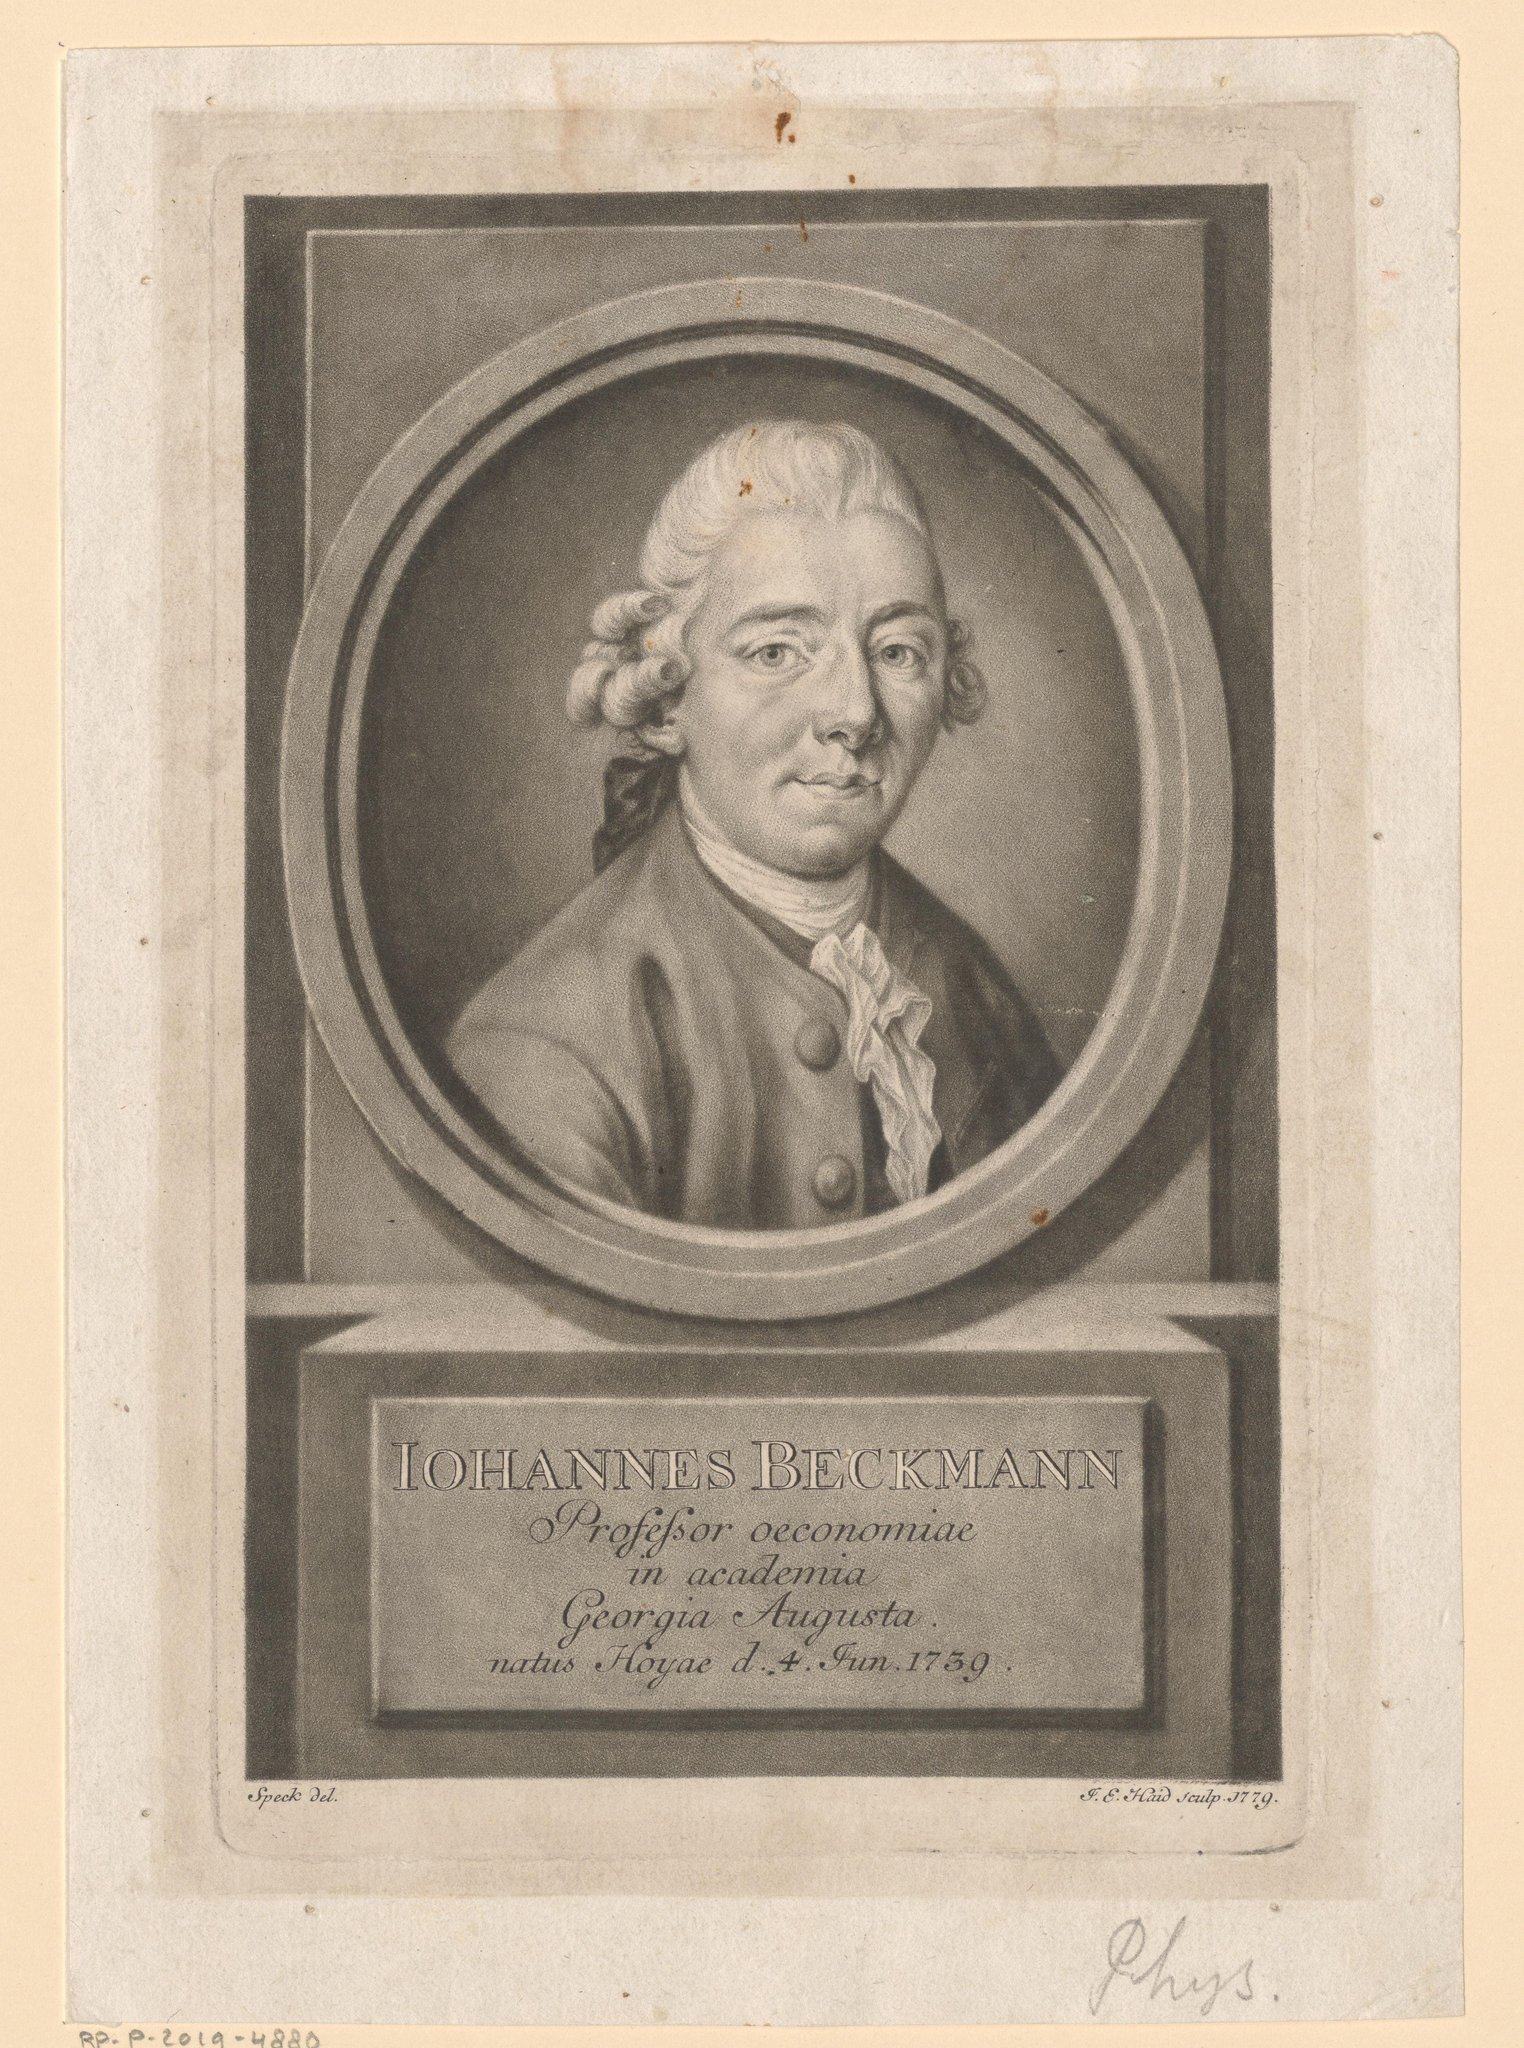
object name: print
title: Portret van Johann Beckmann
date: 1779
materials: paper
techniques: engraving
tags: historical persons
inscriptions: date